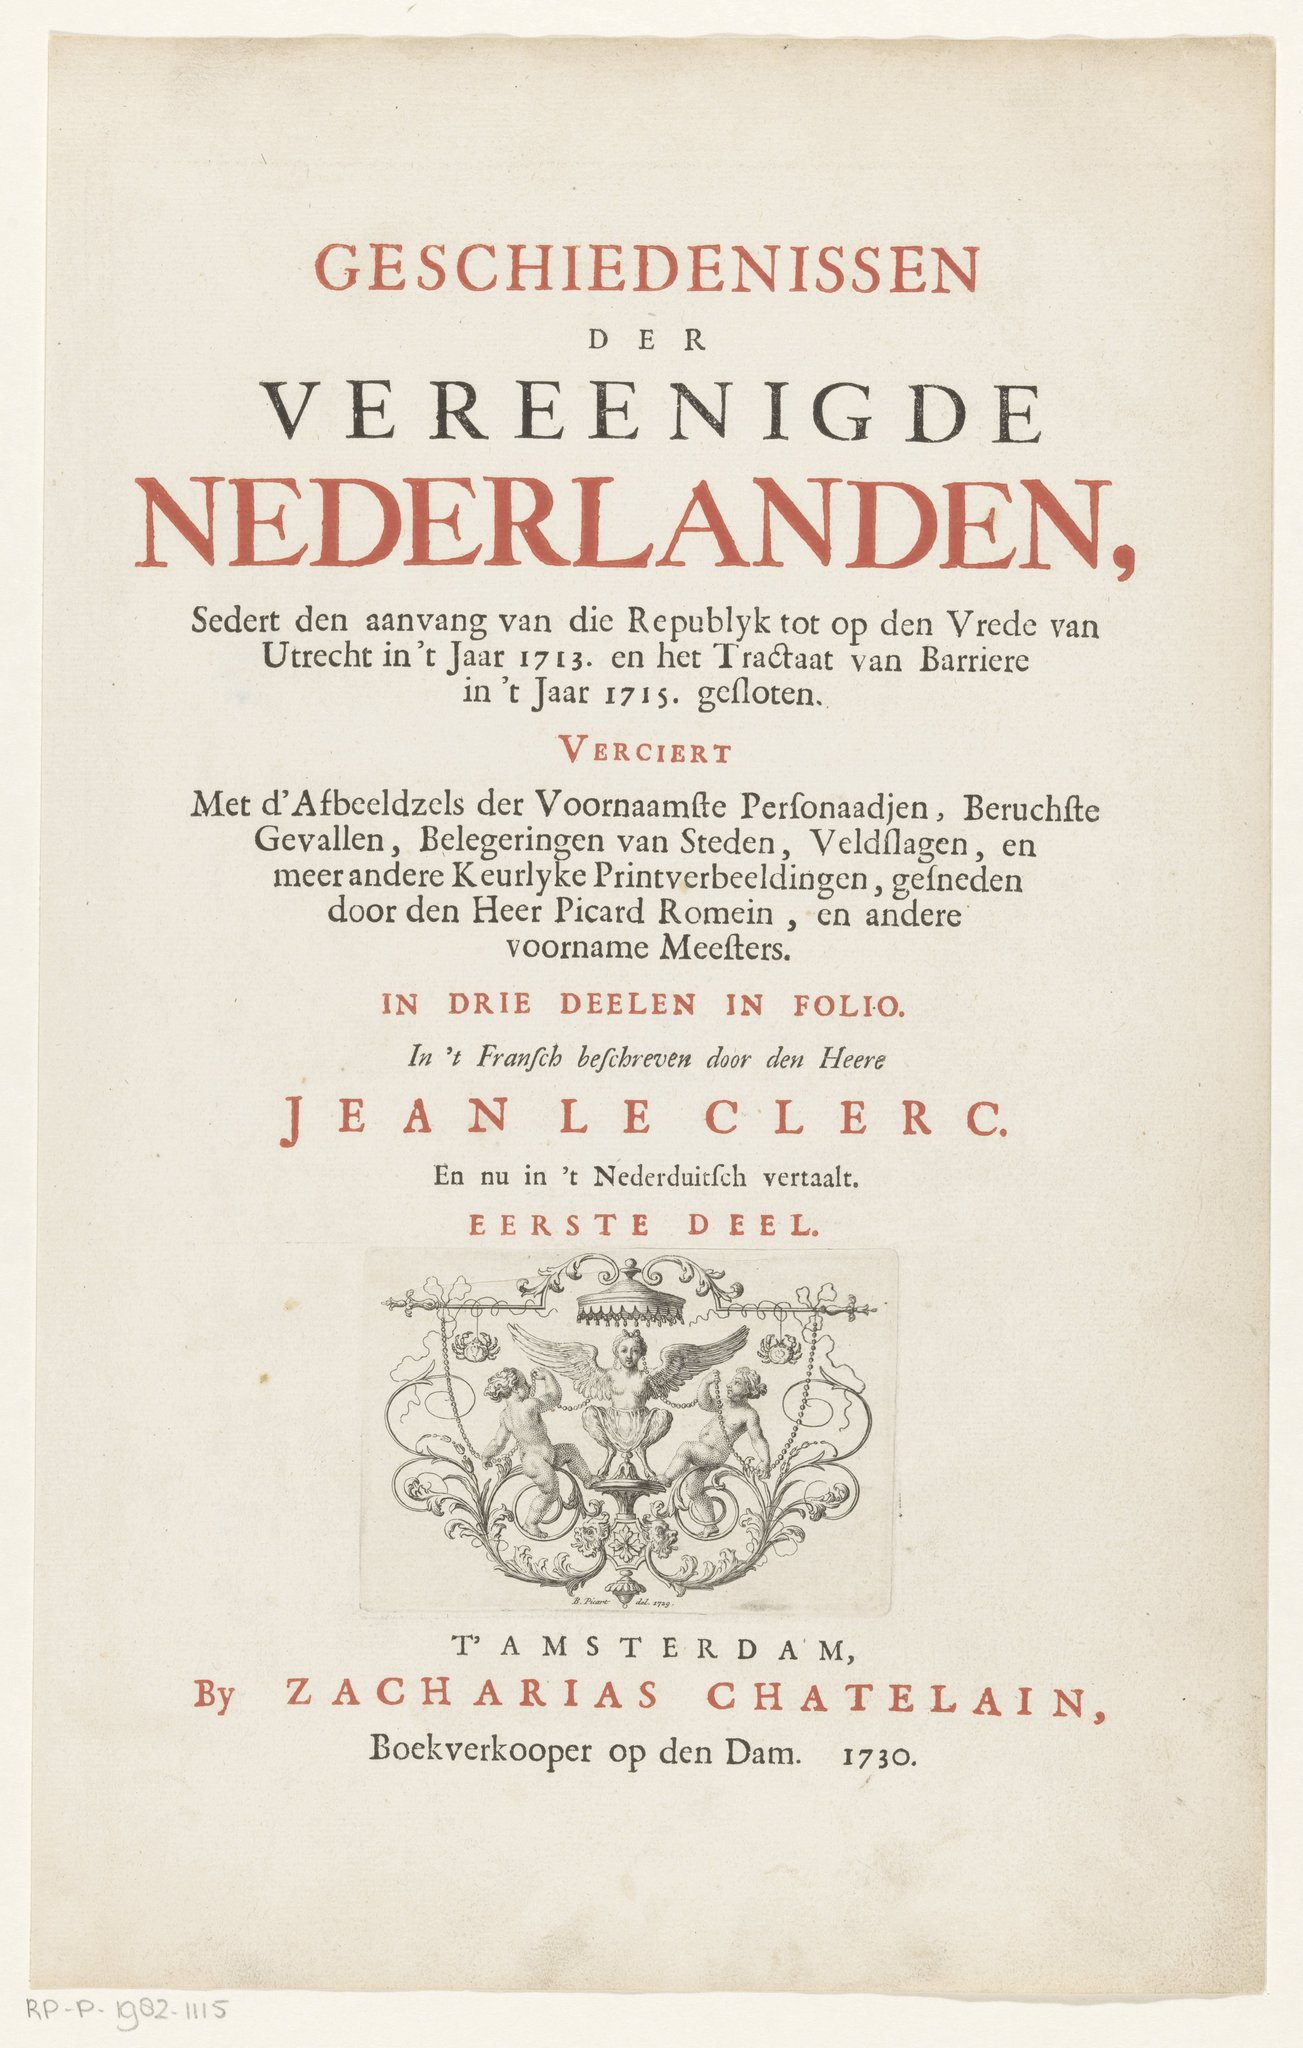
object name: titelblad, titelpagina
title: Titelpagina voor: Jean le Clerc, Geschiedenissen der Vereenigde Nederlanden, eerste deel, 1730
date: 1730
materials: paper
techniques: engraving, etching, letterpress printing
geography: amsterdam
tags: ornaments ~ art, ornament ~ hybrid beings; human and animal forms mixed, cupids: 'amores', 'amoretti', 'putti'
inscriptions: collector's mark: Lugt 2228, collector's mark: Lugt 2760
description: Titelpagina voor: Le Clerc, Jean. Geschiedenissen der Vereenigde Nederlanden, eerste deel. Amsterdam: Chatelain, Zacharias (II), 1730.